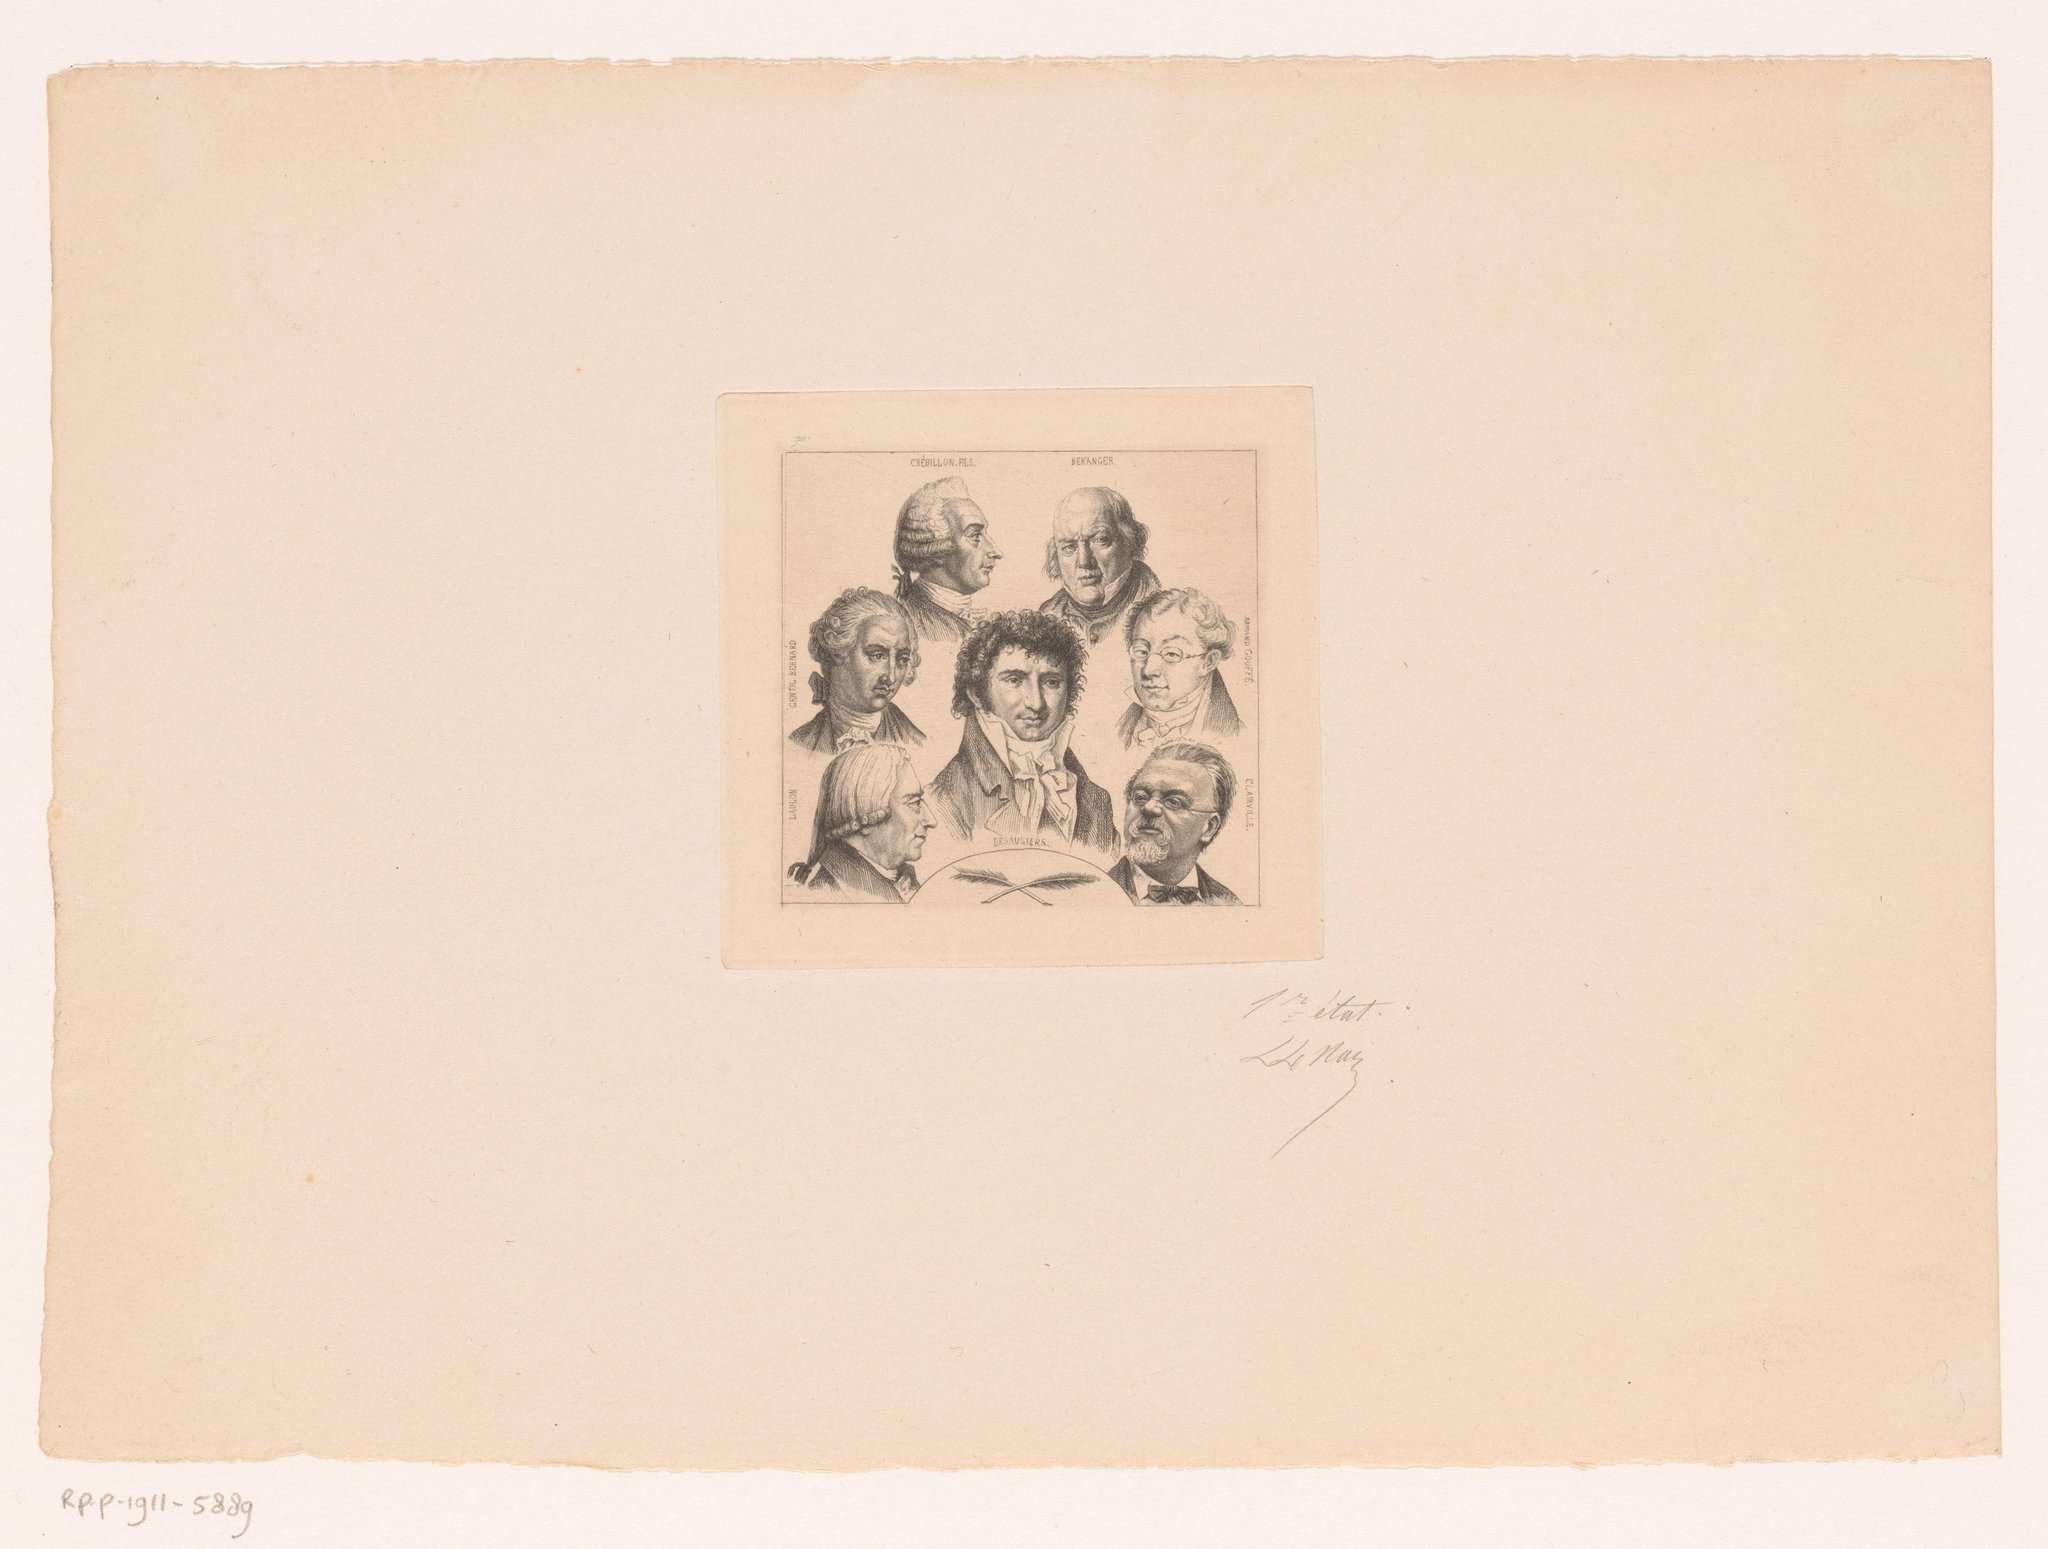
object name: print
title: Portretten van Crébillon, Béranger, Gouffé, Clairville, Désaugiers, Laujon en Bernard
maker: louis le nain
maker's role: print maker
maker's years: 1851-1939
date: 1861-1911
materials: paper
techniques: etching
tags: paris, pierre-jean de béranger, adult man, historical persons, writer, poet, author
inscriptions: collector's mark: Lugt 2228, inscription: ‘1r état LLe Nain’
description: Onder de portretten twee gekruiste veren.